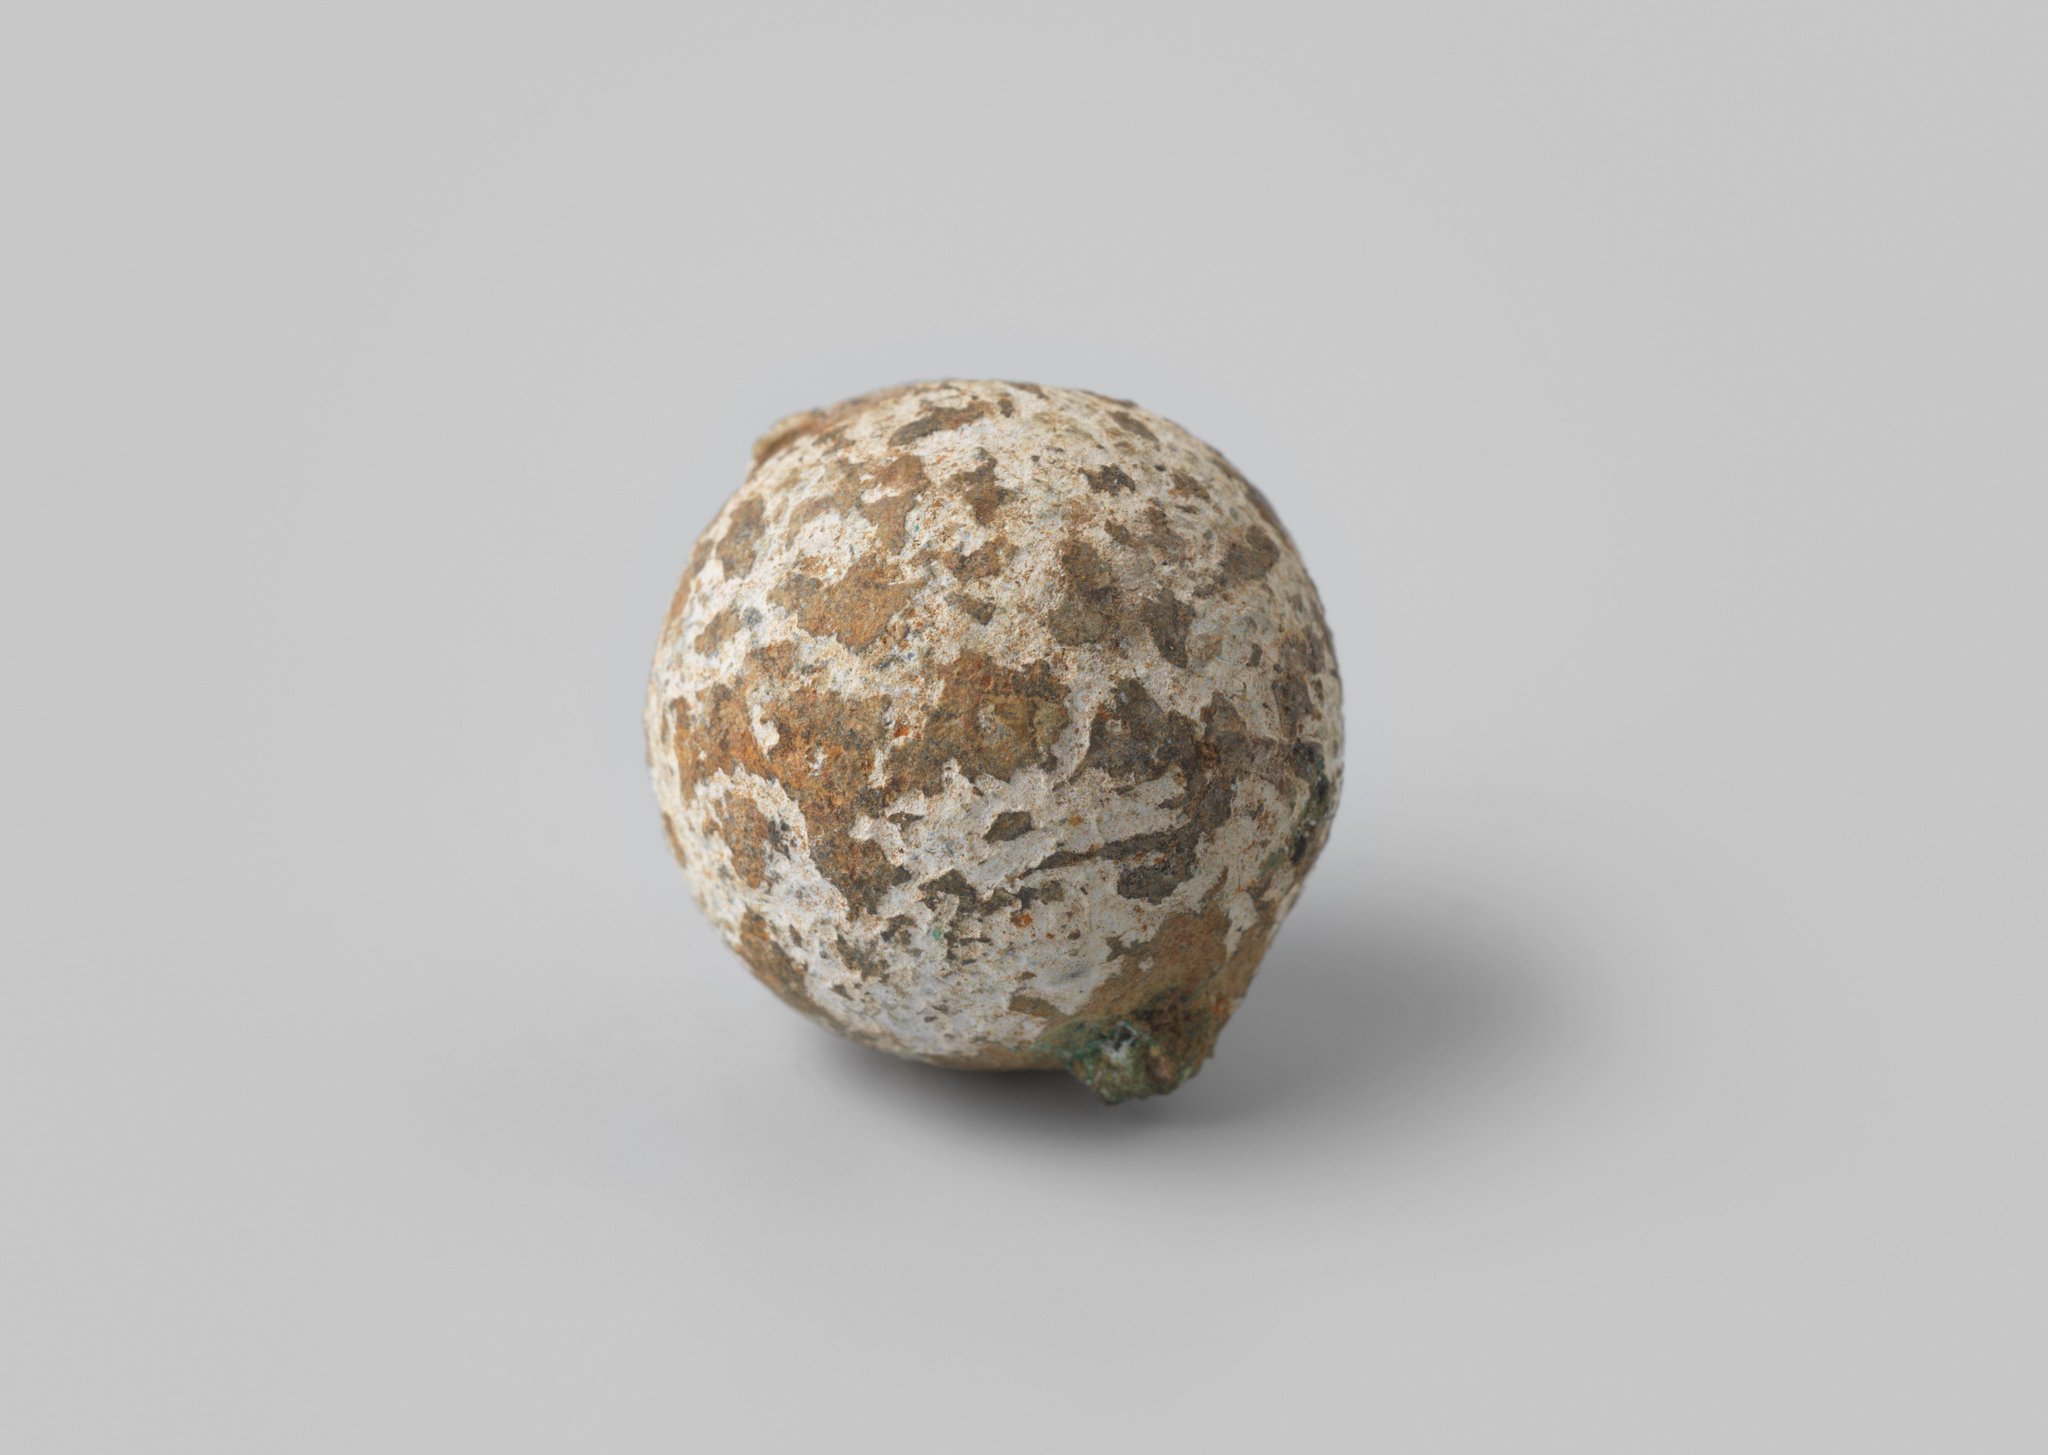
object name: musketkogel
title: Musketkogel uit het wrak van de Oost-Indiëvaarder Hollandia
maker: Anonymous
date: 1700-1743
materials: lead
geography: netherlands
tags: verenigde oostindische compagnie, hollandia (schip), annet